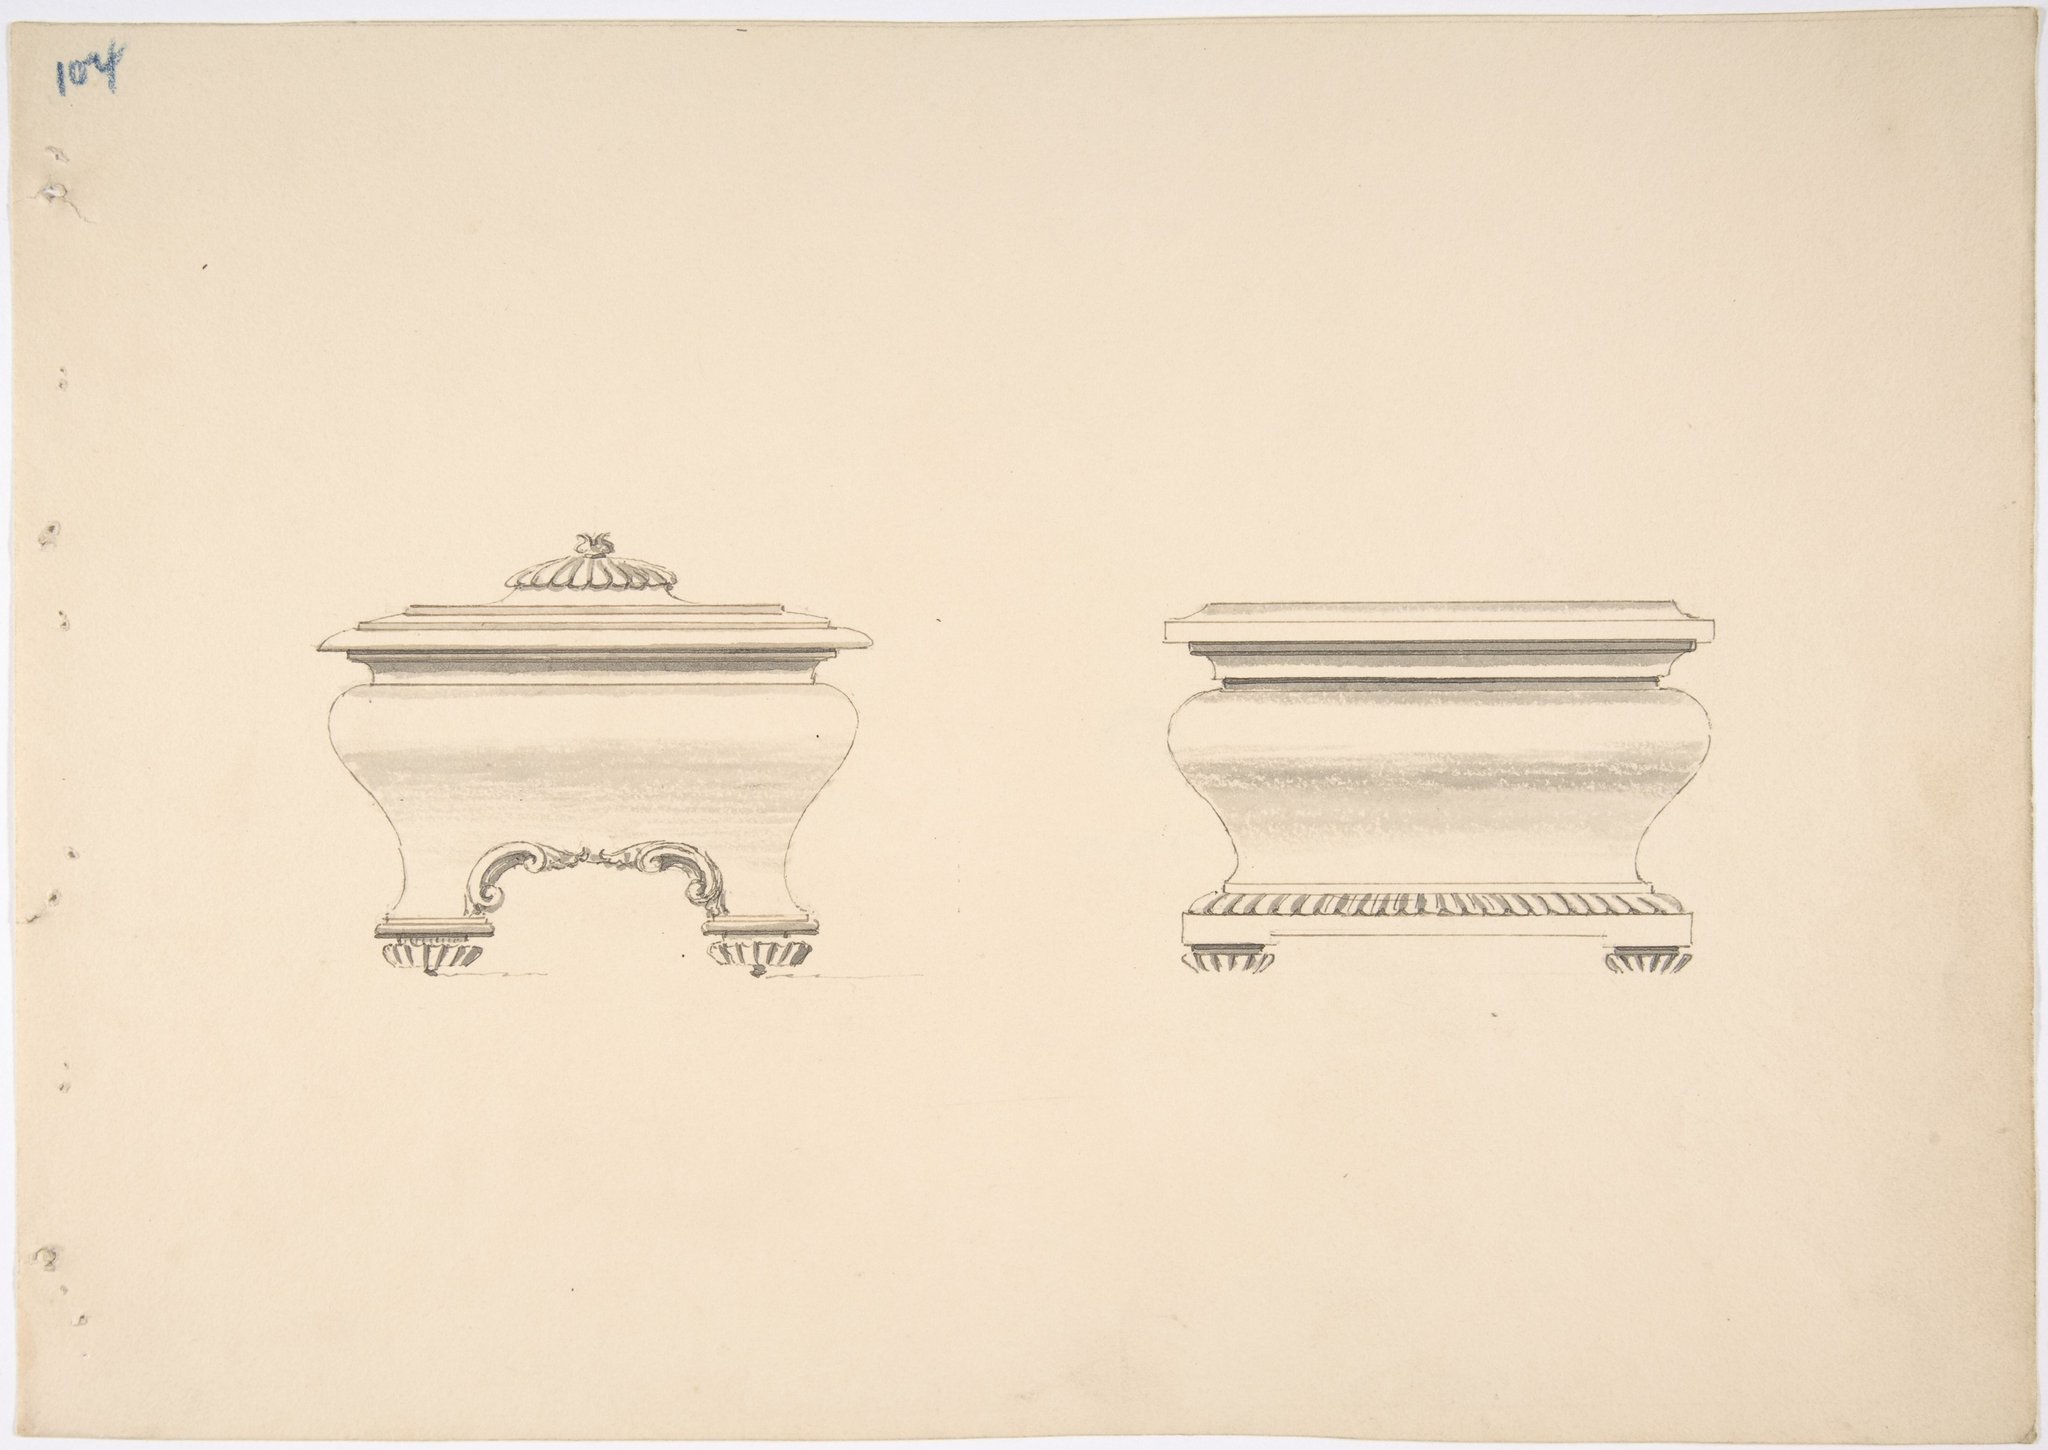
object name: drawing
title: Design for Two Caskets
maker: anonymous, british, 19th century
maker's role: artist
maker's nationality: british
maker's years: 1800-1900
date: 1801-1833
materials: ink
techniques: brush, pen, wash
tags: furniture